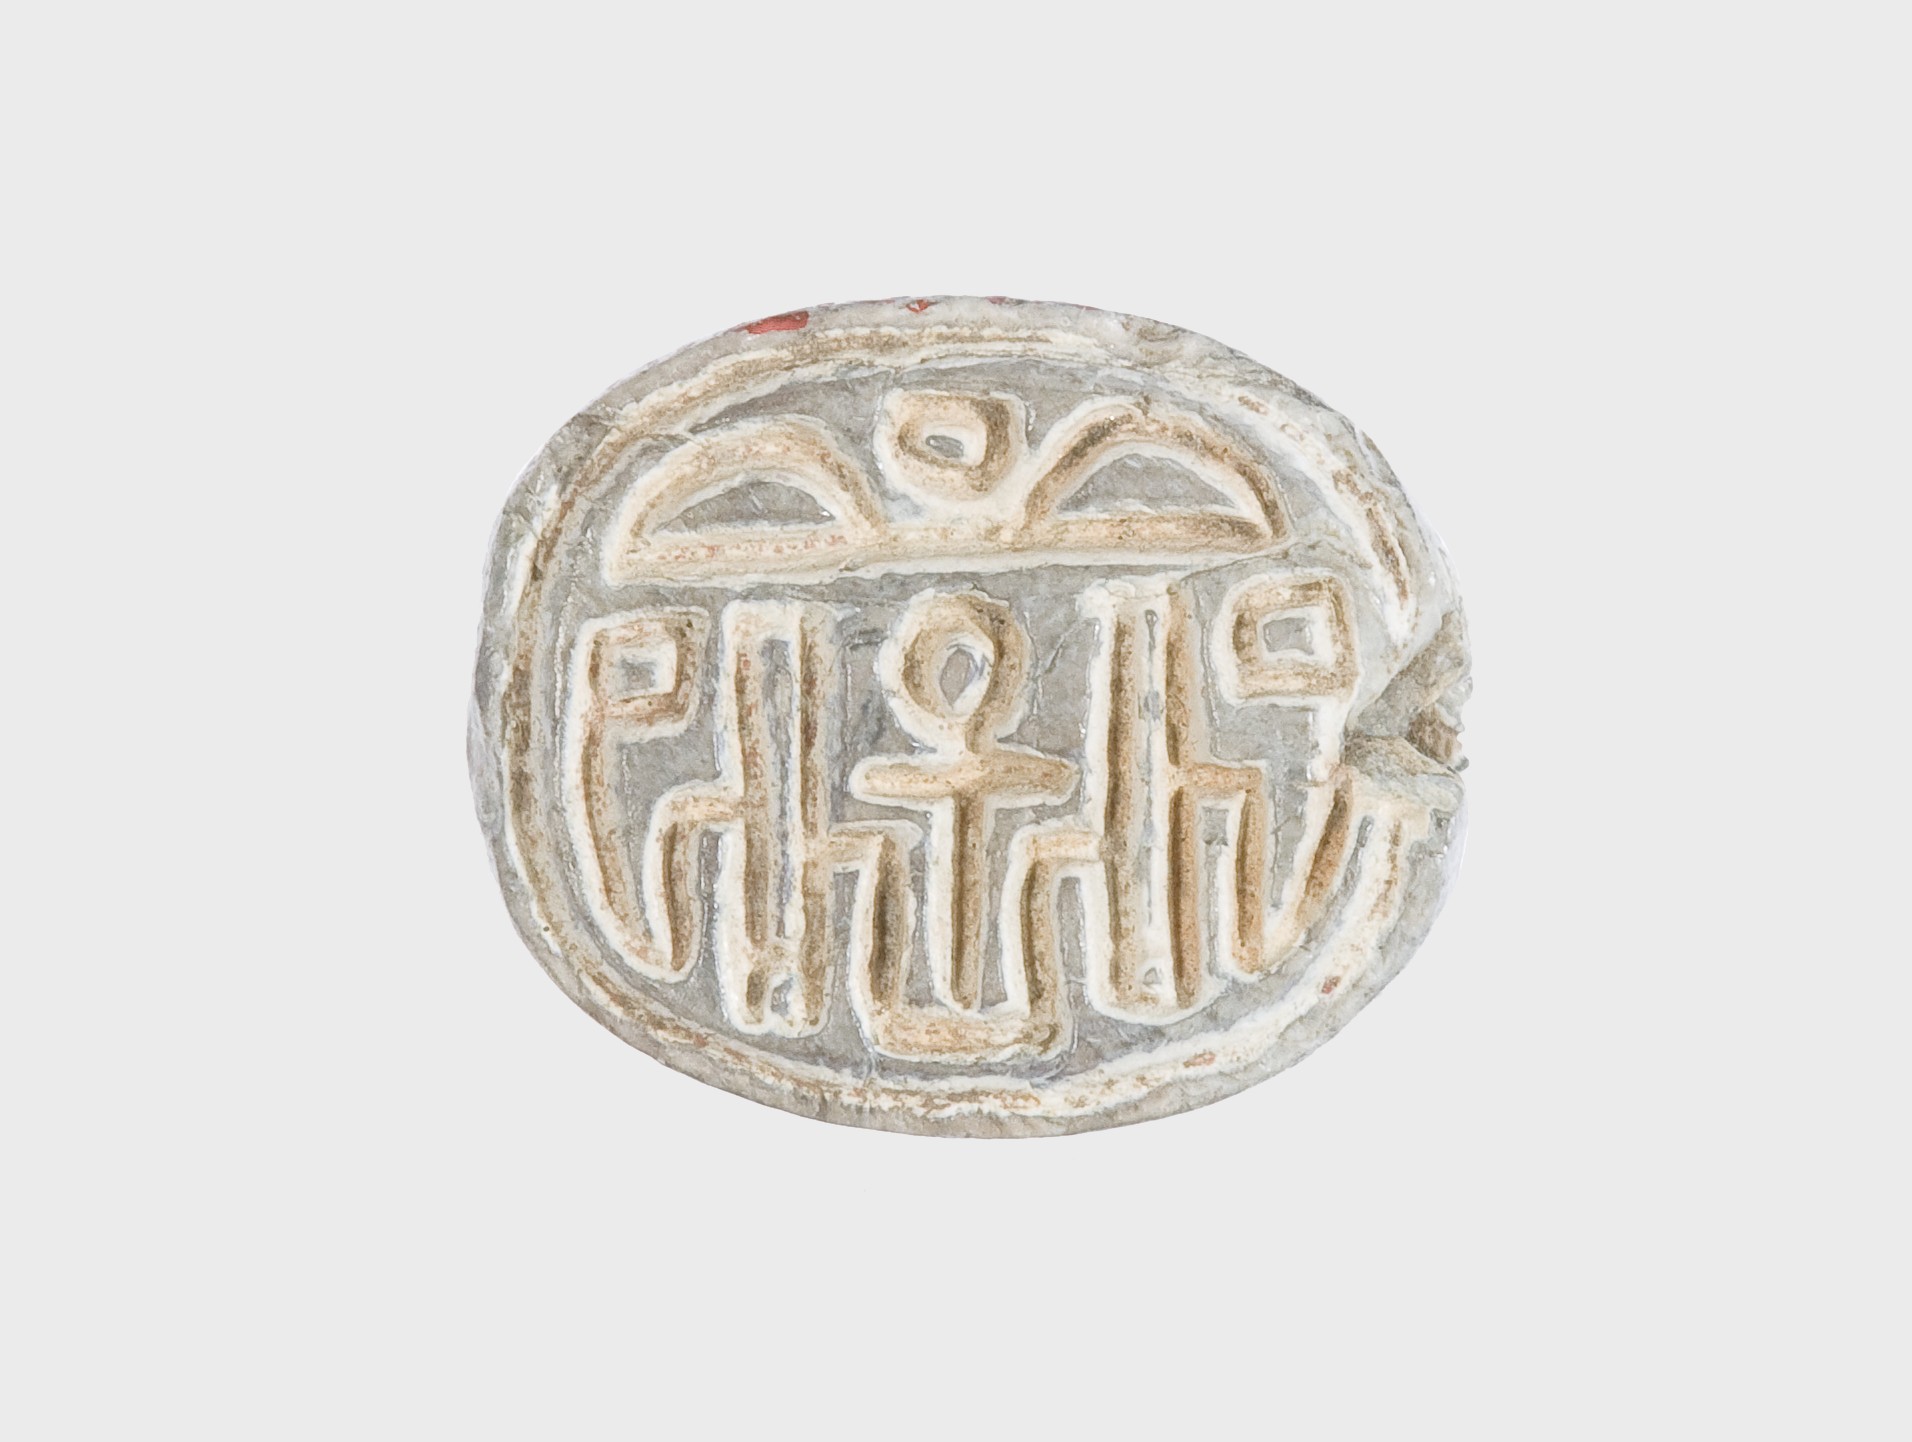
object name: scarab, ankh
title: Scarab Inscribed with a Geometric Pattern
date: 1390-1352 BCE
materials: mica, stone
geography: egypt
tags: scarabs